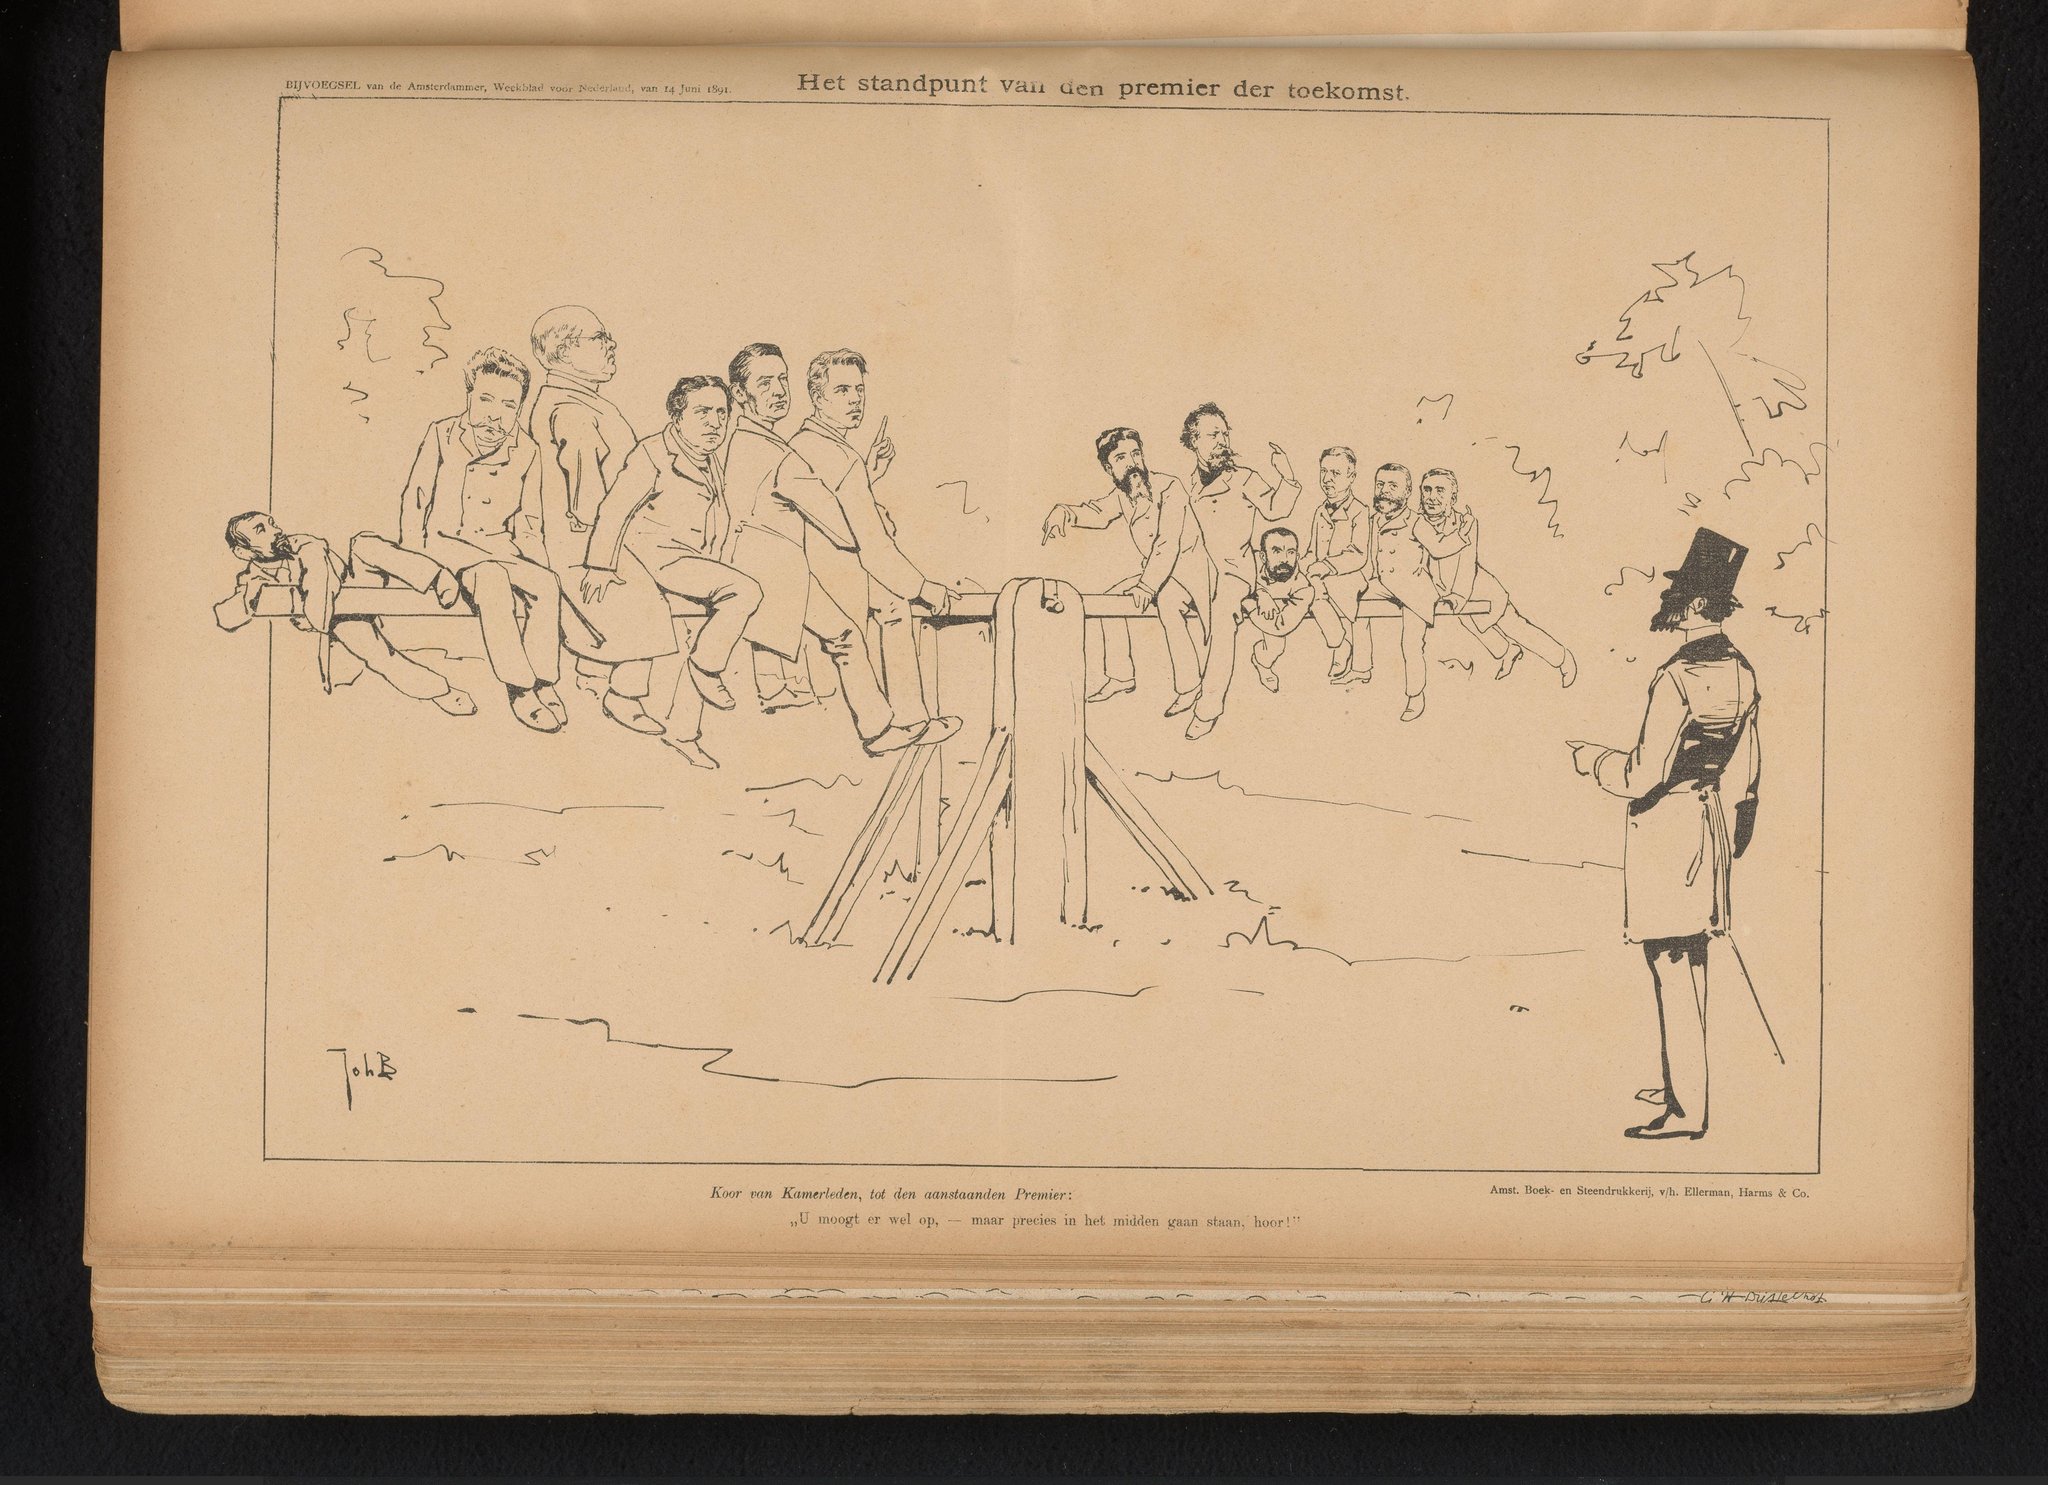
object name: cartoon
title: Het standpunt van den premier der toekomst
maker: johan braakensiek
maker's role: draughtsman, print maker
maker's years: 1858-1940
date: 1891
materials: paper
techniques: lithograph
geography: amsterdam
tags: mayor, gijsbert van tienhoven, member of parliament, politician, e.g. party leader, political caricatures and satires, seesaw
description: Een wip wordt in evenwicht gehouden door de twee groepen Kamerleden die erop zitten. Beide zijden willen dat de aanstaande premier, in wiens profiel Gijsbert van Tienhoven is te herkennen, precies in het midden komt zitten.